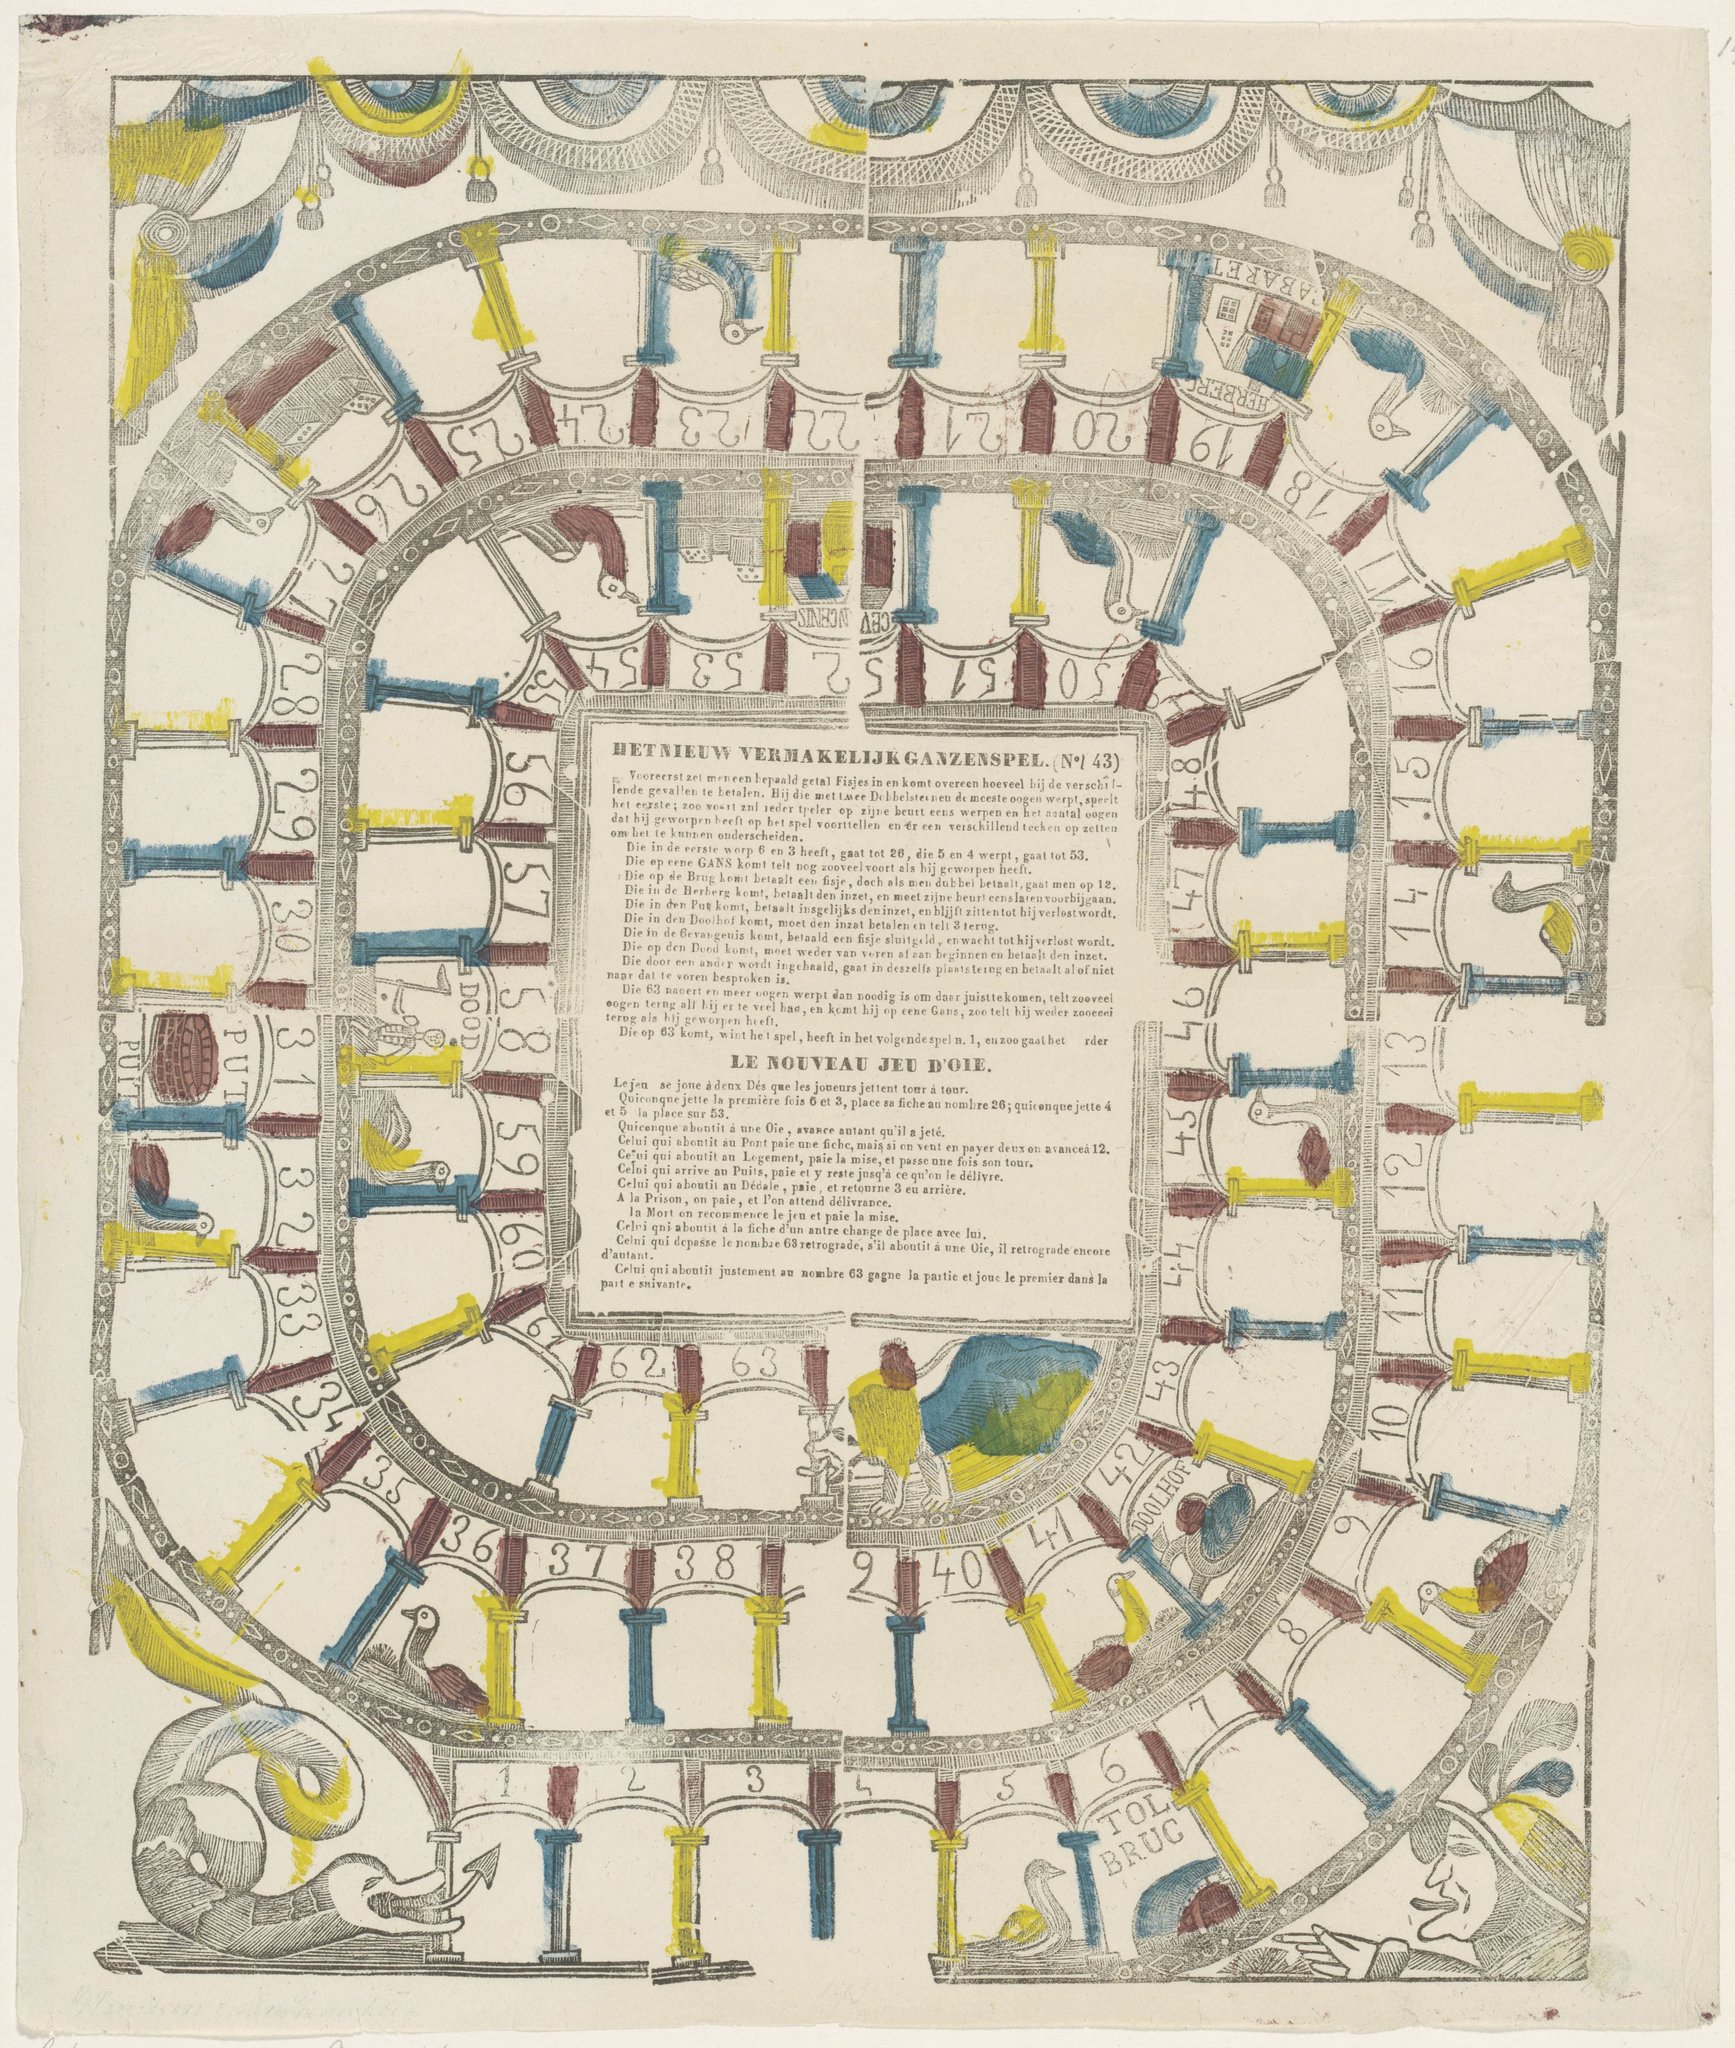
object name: game of goose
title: Het nieuw vermakelijk ganzenspel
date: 1856-1870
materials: paper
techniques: colour, letterpress printing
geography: turnhout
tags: goose-game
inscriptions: collector's mark: Lugt 2760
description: Ganzenbordspel met een spiraal met vakjes genummerd van 1 tot en met 63. In enkele vakjes voorstellingen van ganzen. Op het middenveld de spelregels in boekdruk in het Nederlands en in het Frans. Genummerd: No. 143.